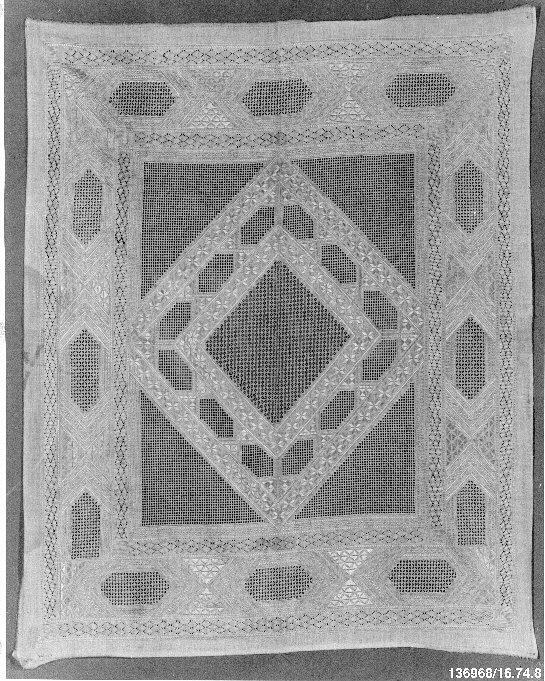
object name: cover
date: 1867-1900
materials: linen, silk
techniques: embroidery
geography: iran